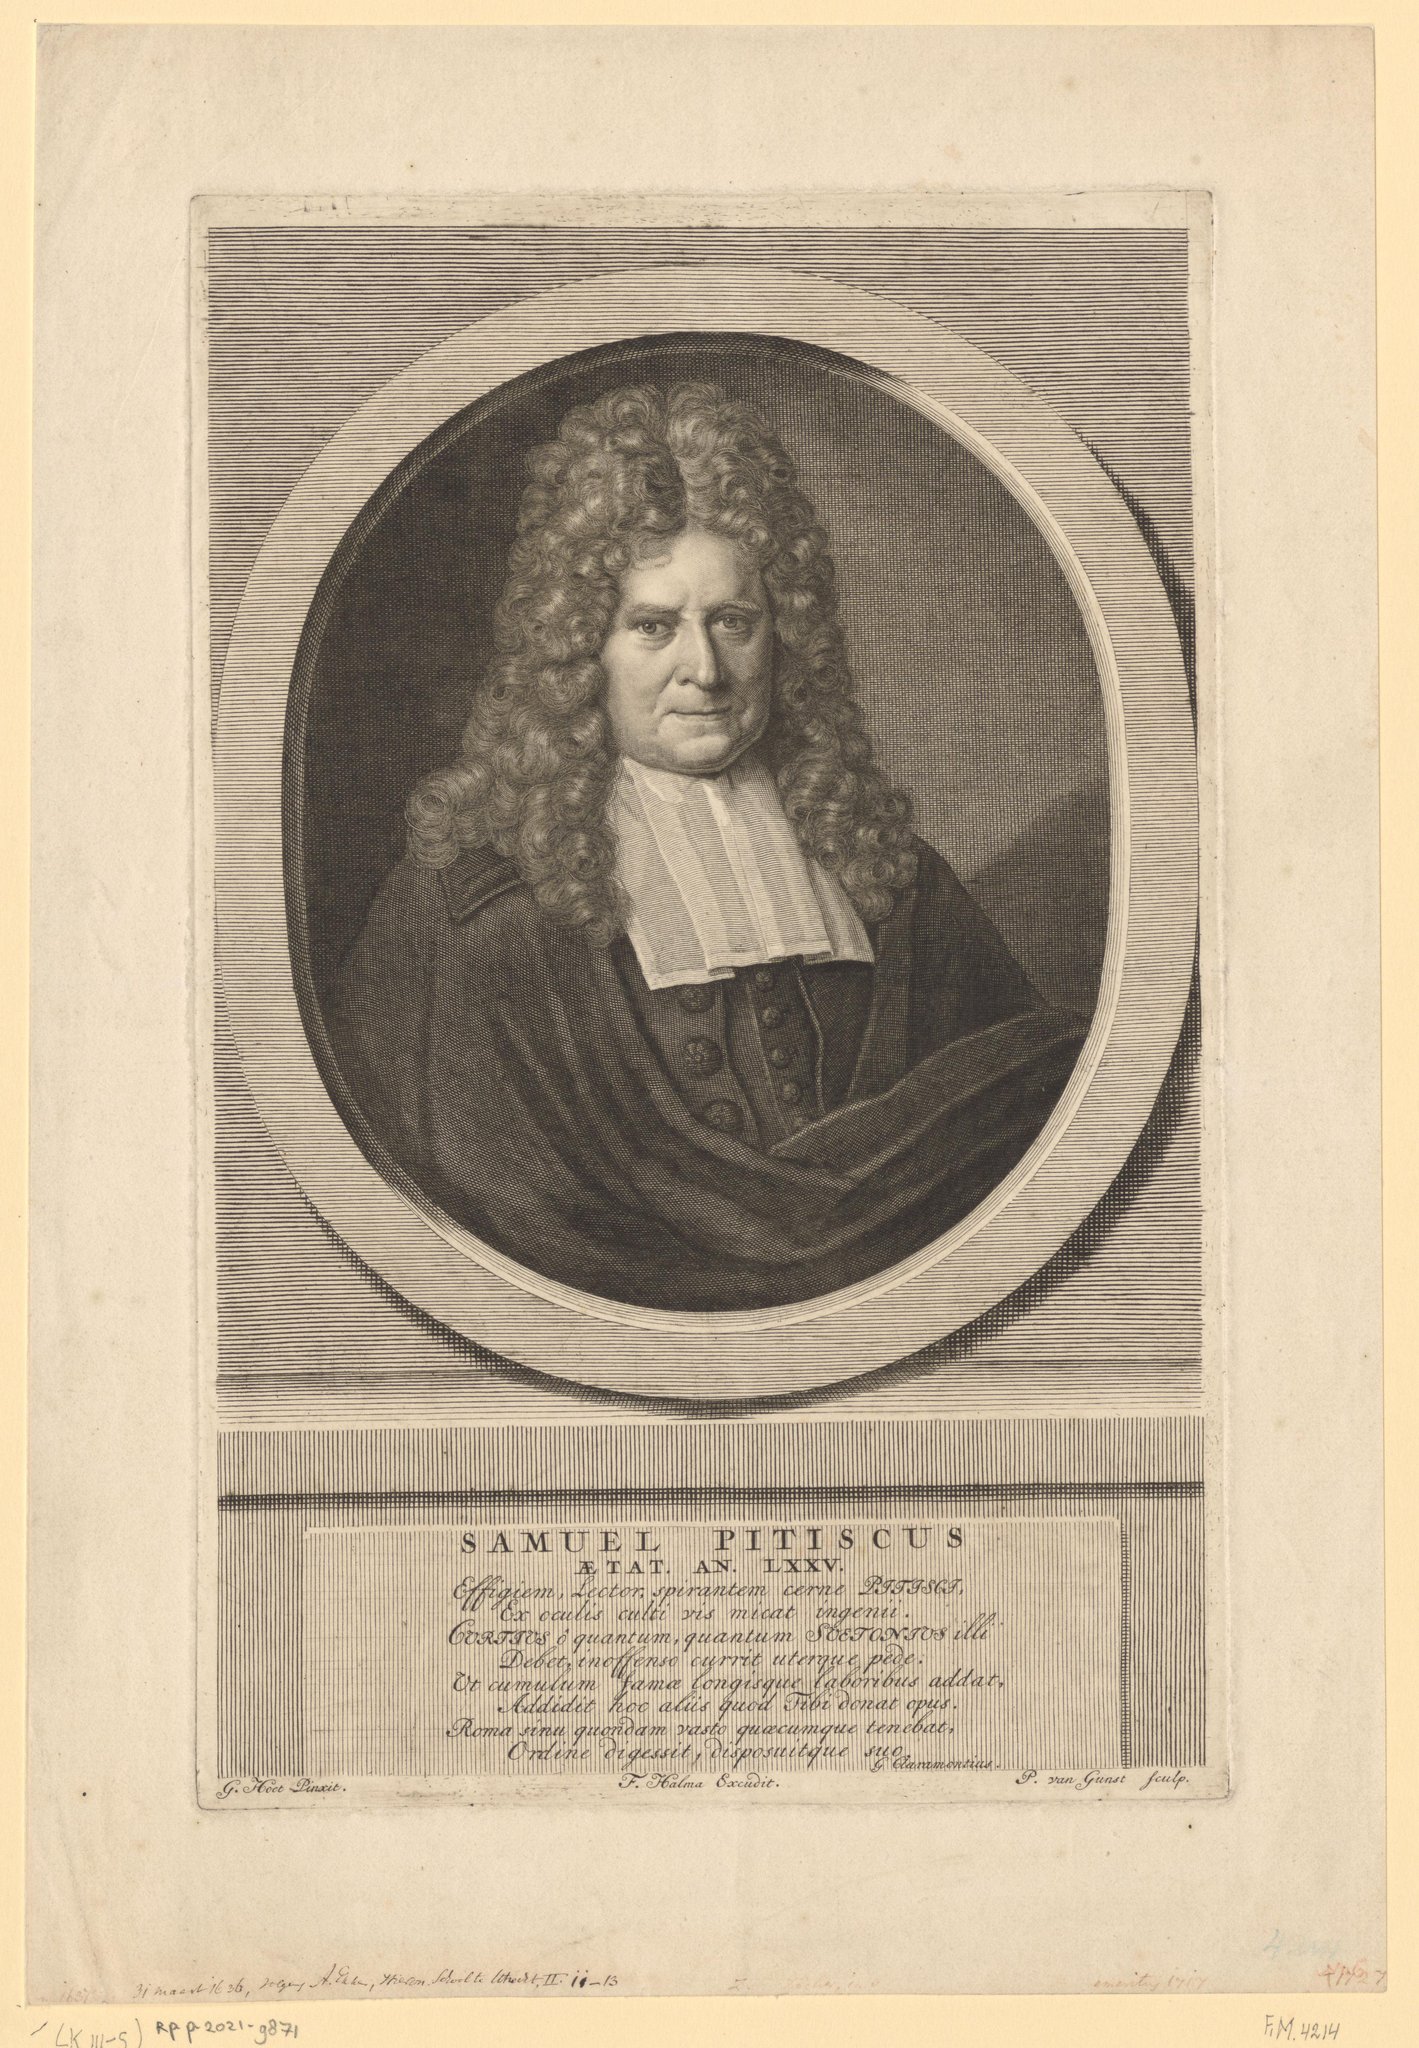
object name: print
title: Portret van Samuel Pitiscus op 75-jarige leeftijd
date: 1712-1731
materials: paper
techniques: engraving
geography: amsterdam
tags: samuel pitiscus, adult man, historical persons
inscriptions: inscription: ‘31 maart 1636, volgens A.[...] School te Utrecht, II. ii-13’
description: Samuel Pitiscus, een klassieke geleerde uit Zutphen, op zijn 75-jarige leeftijd. De prent heeft een Latijns onderschrift.